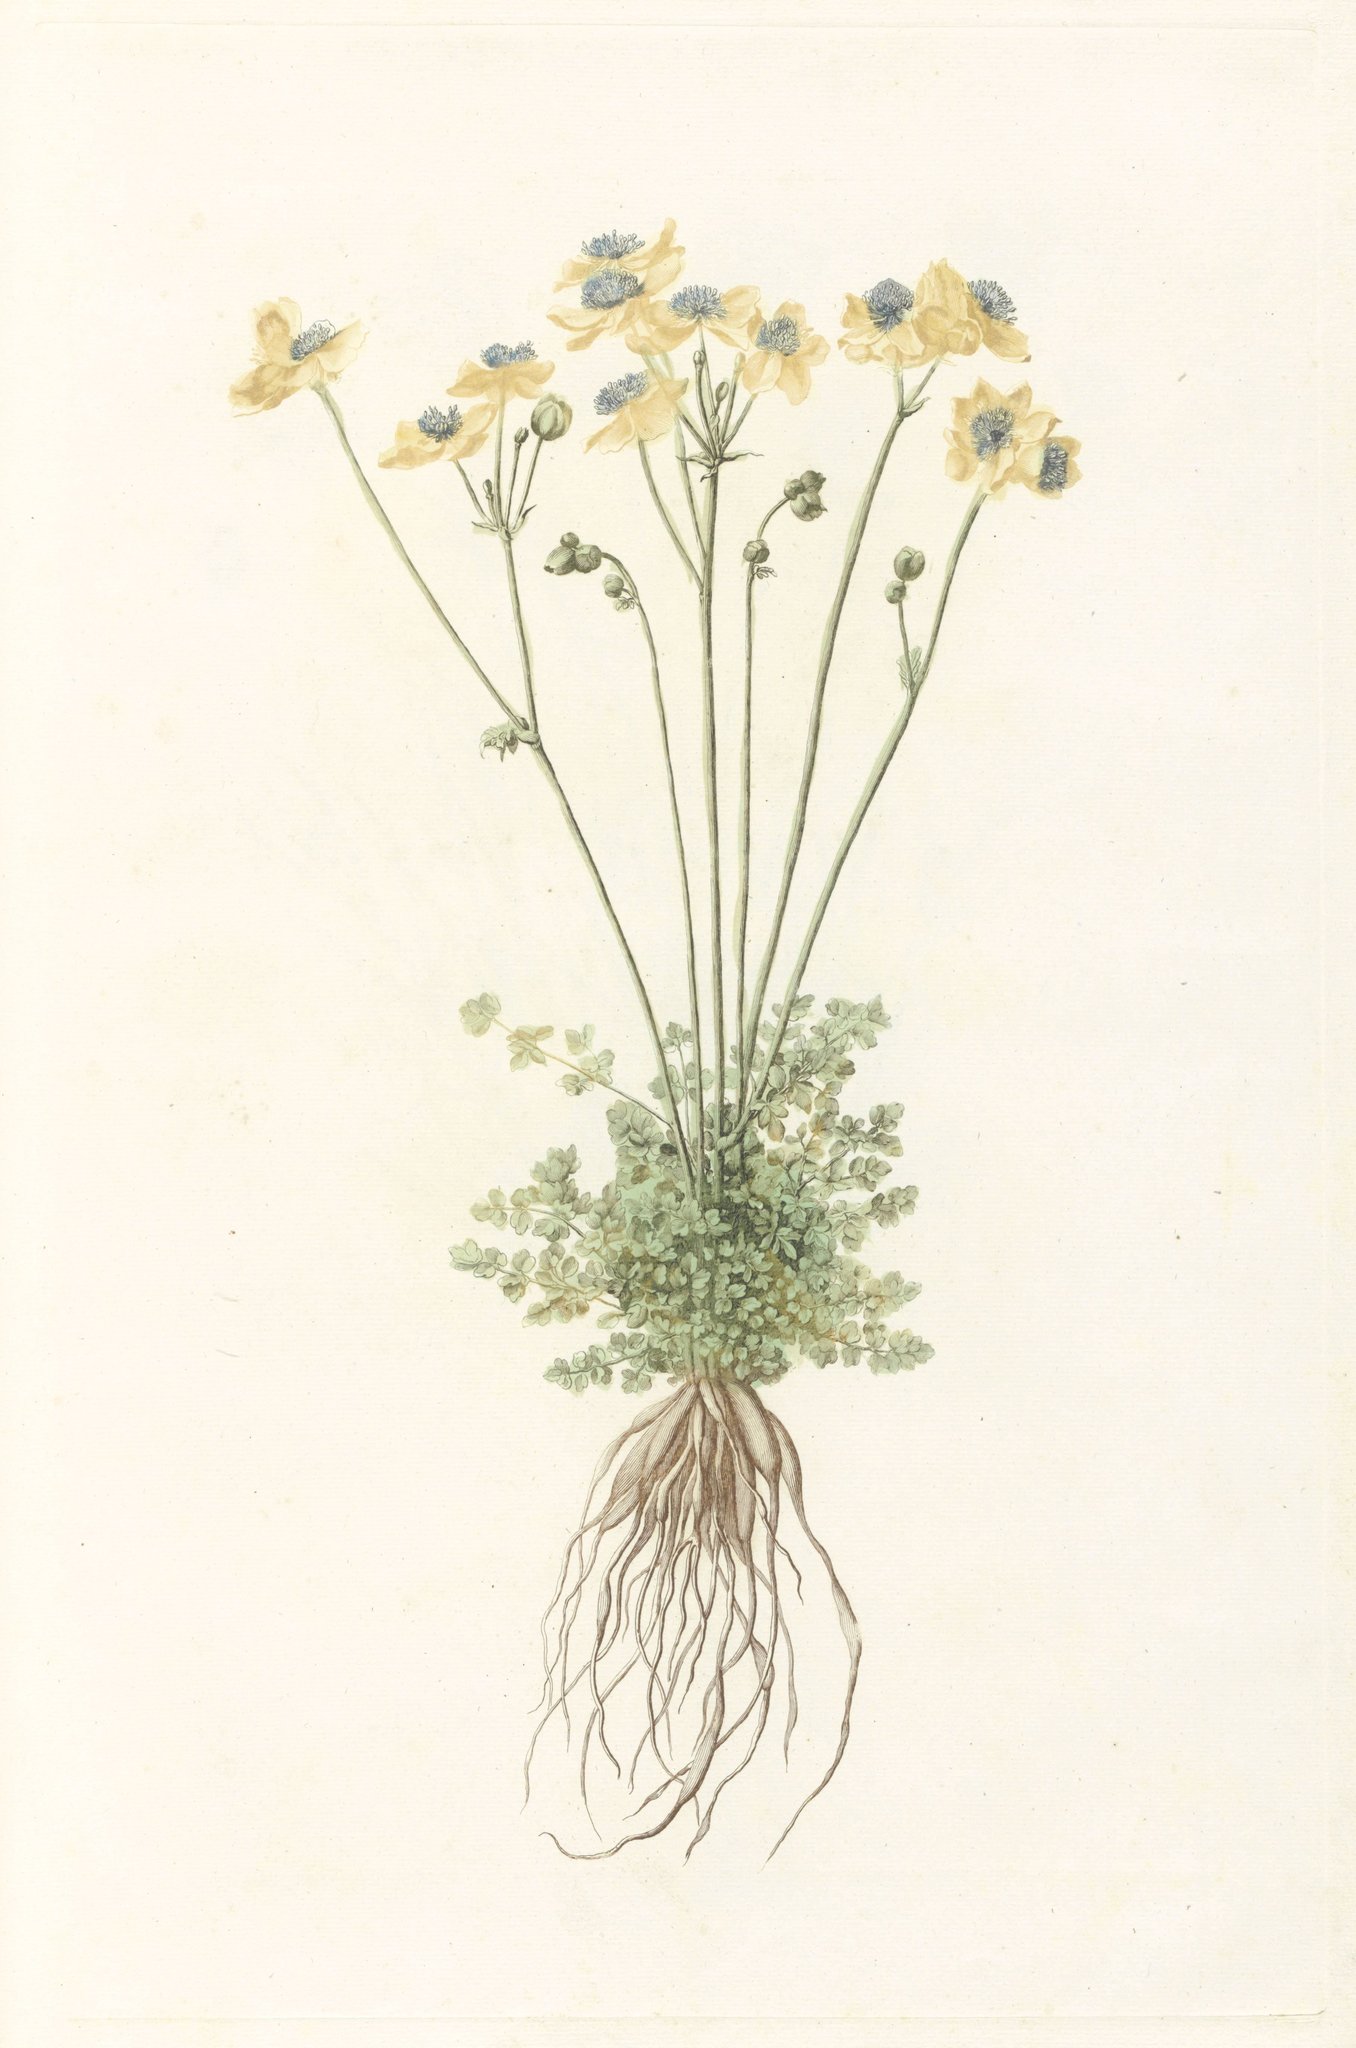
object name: print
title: Bloeiende plant met wortels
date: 1688-1698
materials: paper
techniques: printing, engraving, hand coloring, lithography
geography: netherlands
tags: flowers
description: Deze prent maakt deel uit van een album.